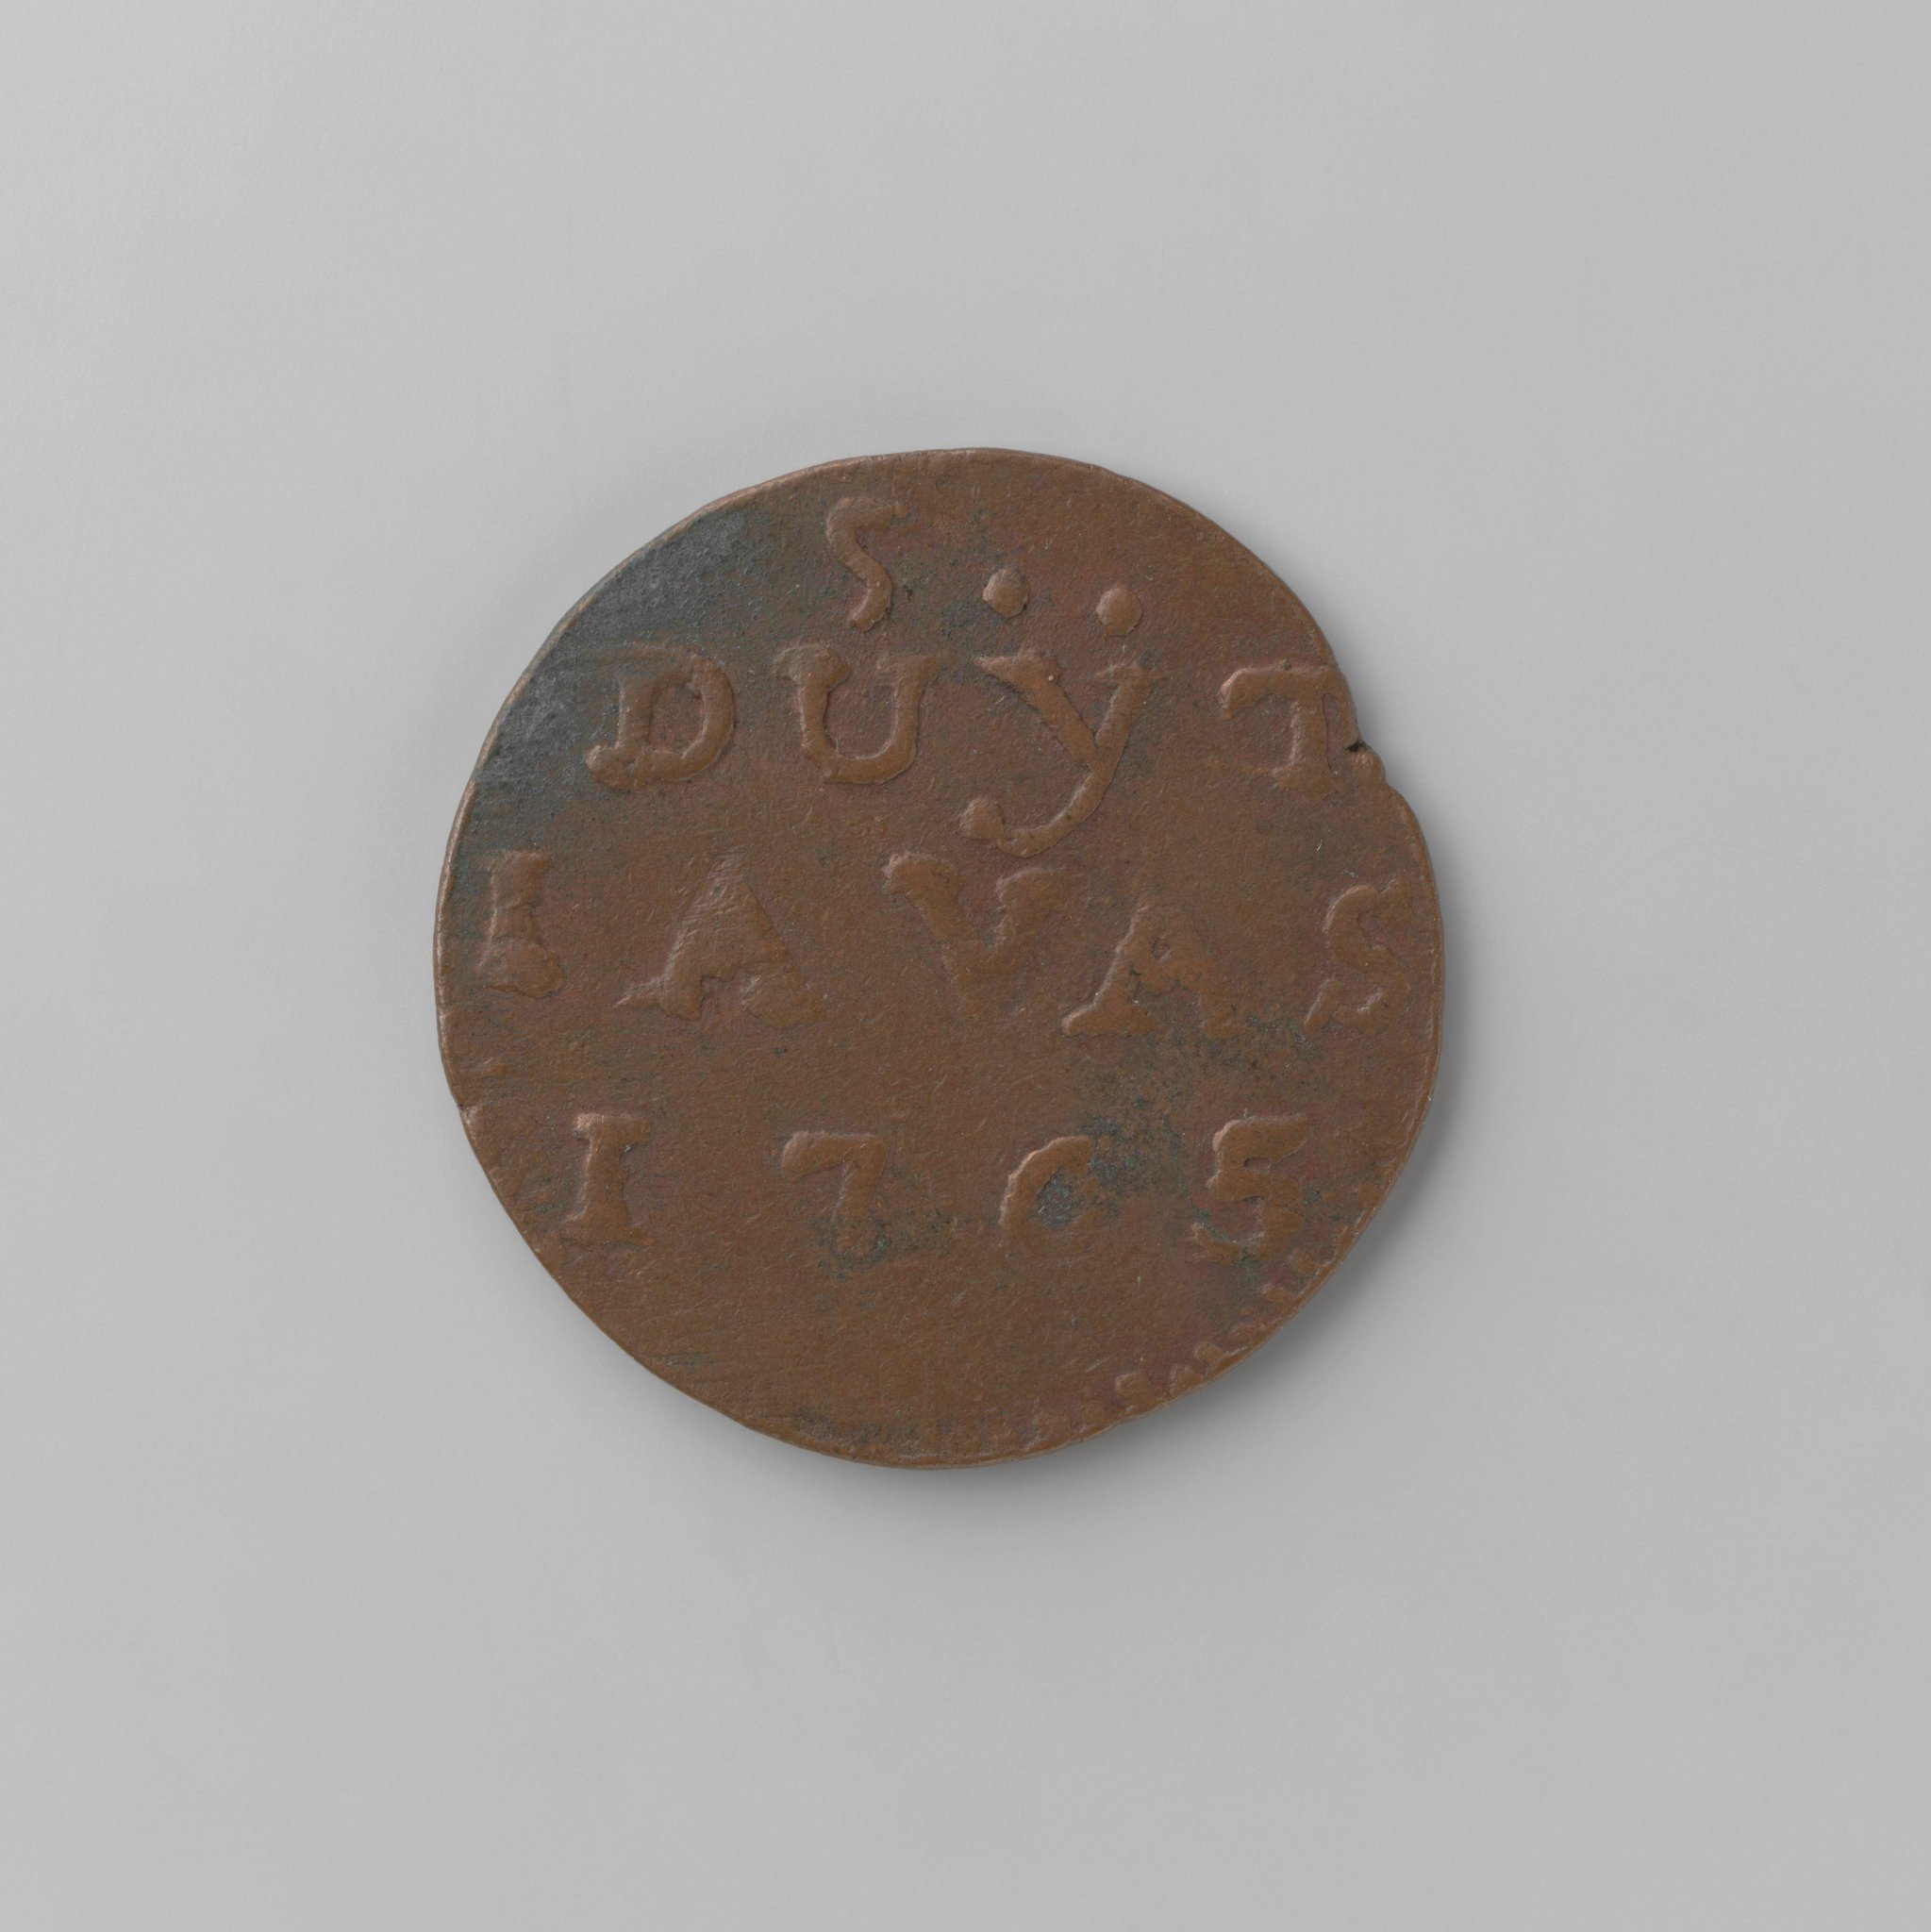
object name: coin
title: VOC, Javase duit,1765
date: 1765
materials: copper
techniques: striking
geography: batavia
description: Koperen munt. Voorzijde: tweeregelig opschrift in Latijnse letters. Daaronder jaartal in aangepaste Arabische cijfers. Keerzijde: Eensluidend tweeregelig opschrift in Arabische letters. Daaronder jaartal in oorspronkelijke Arabische cijfers. Gladde rand.